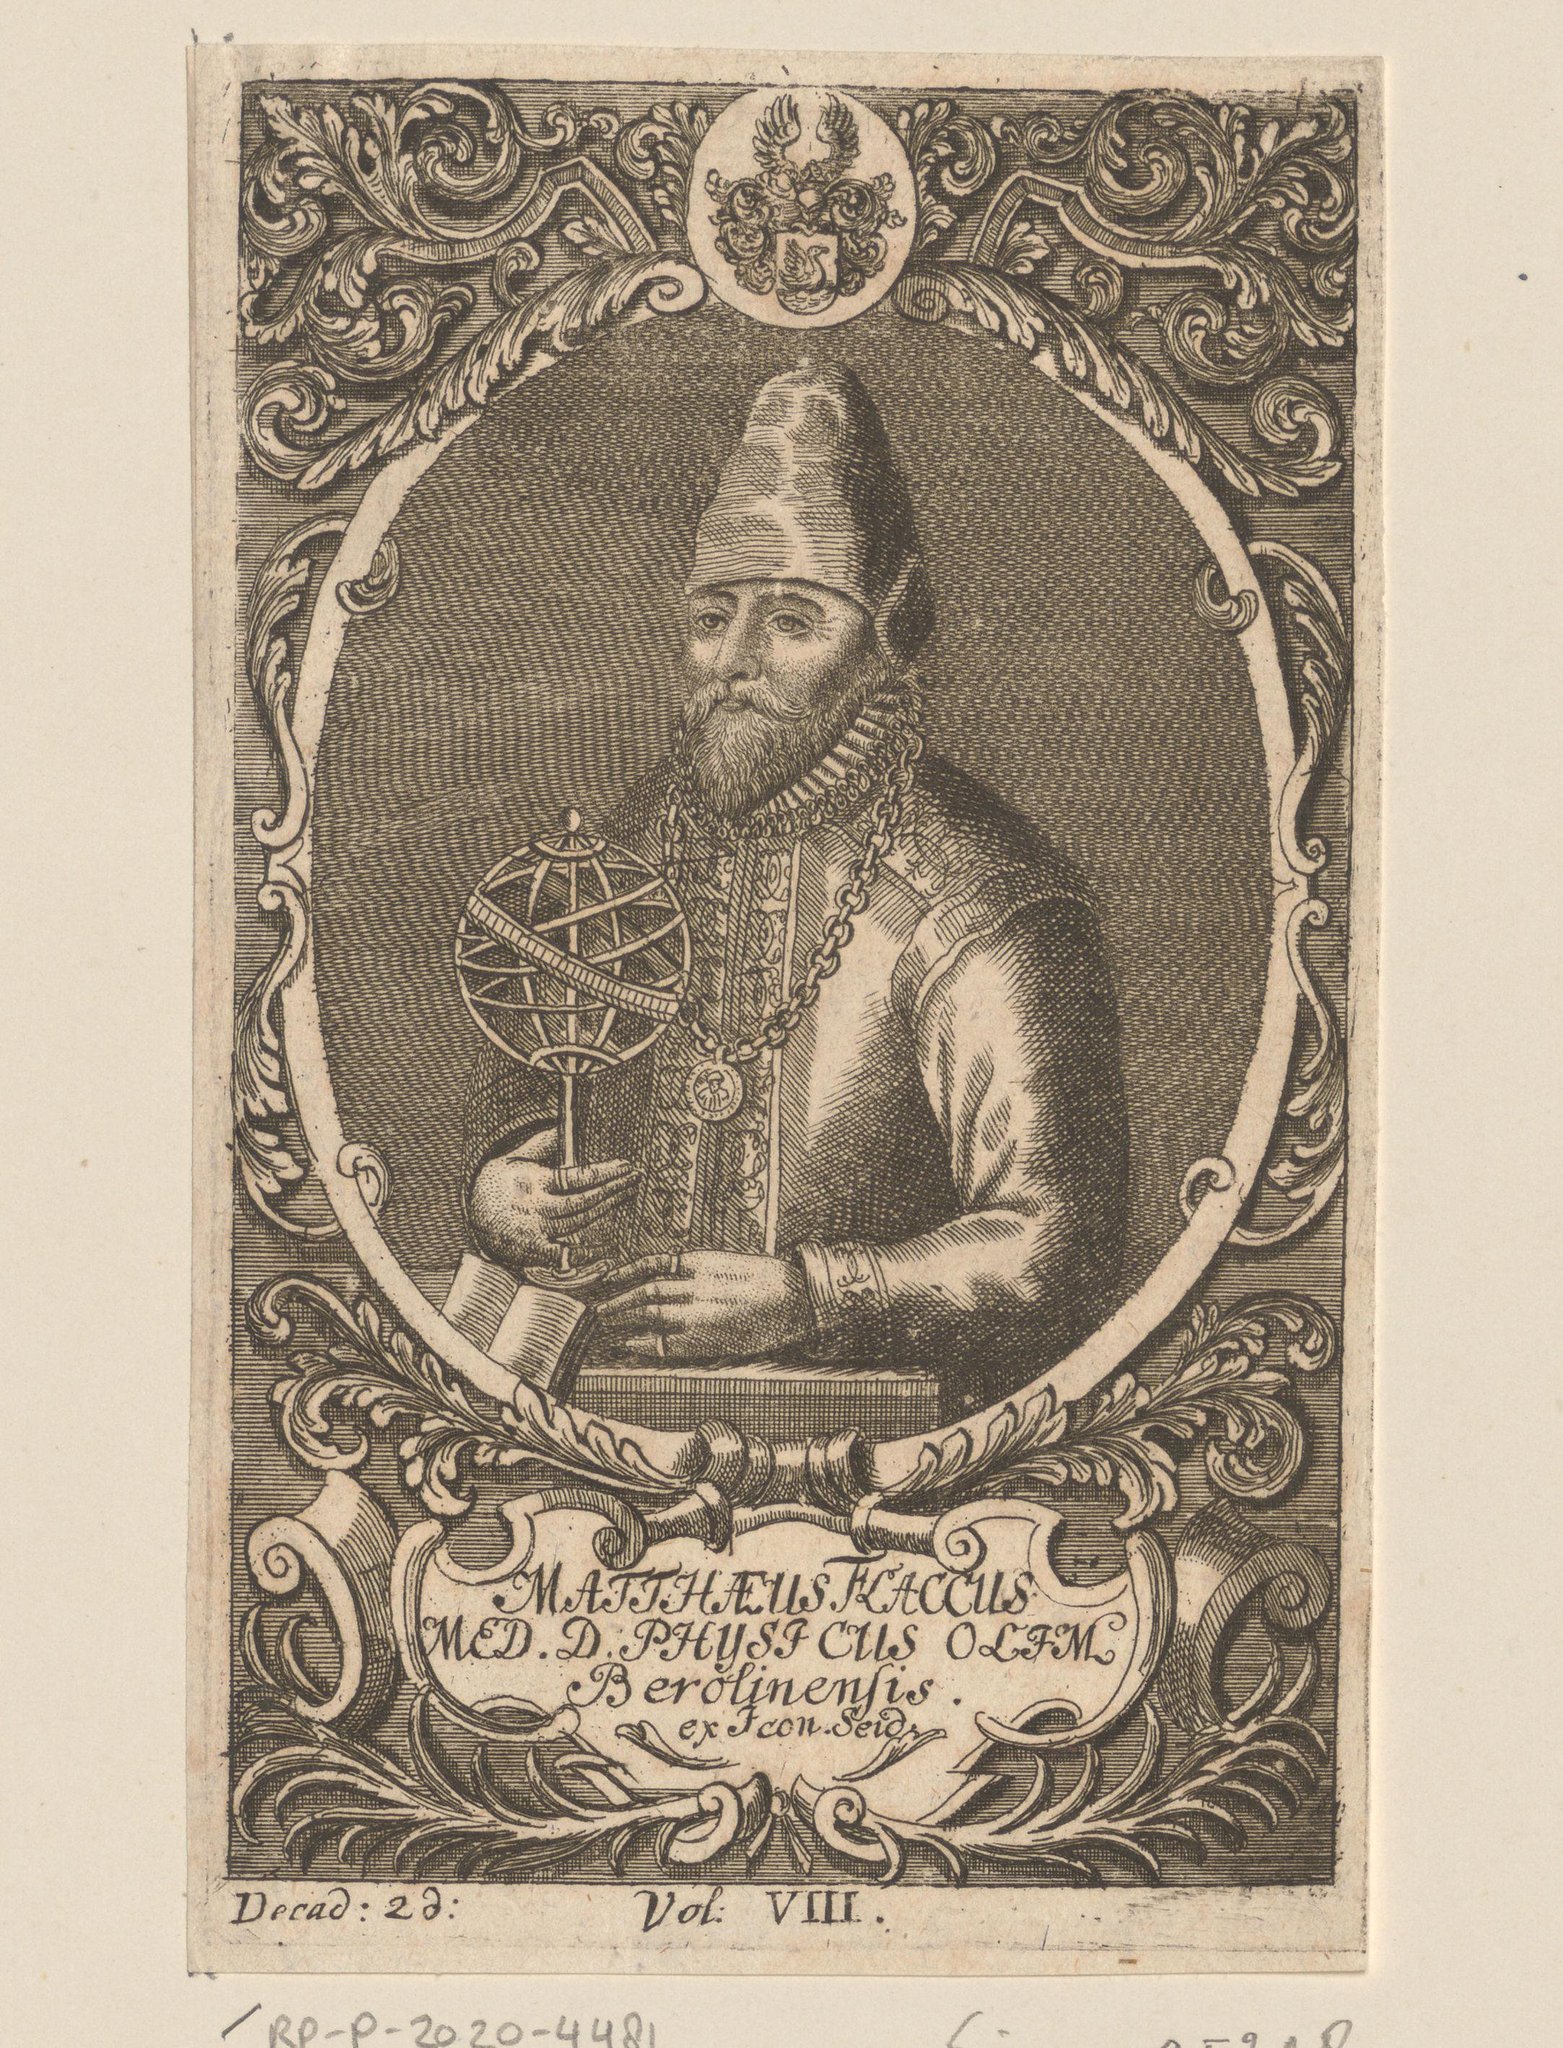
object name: print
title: Portret van Matthaeus Fleck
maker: Anonymous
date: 1728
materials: paper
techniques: engraving, etching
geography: germany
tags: historical persons, book, armillary sphere, skeleton celestial globe, armorial bearing, heraldry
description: Prent waarschijnlijk uit: Decad. II. Actorum medicorum berolinensium (...). Berlijn: Gottfried Gedicke, 1728, dl. 8.